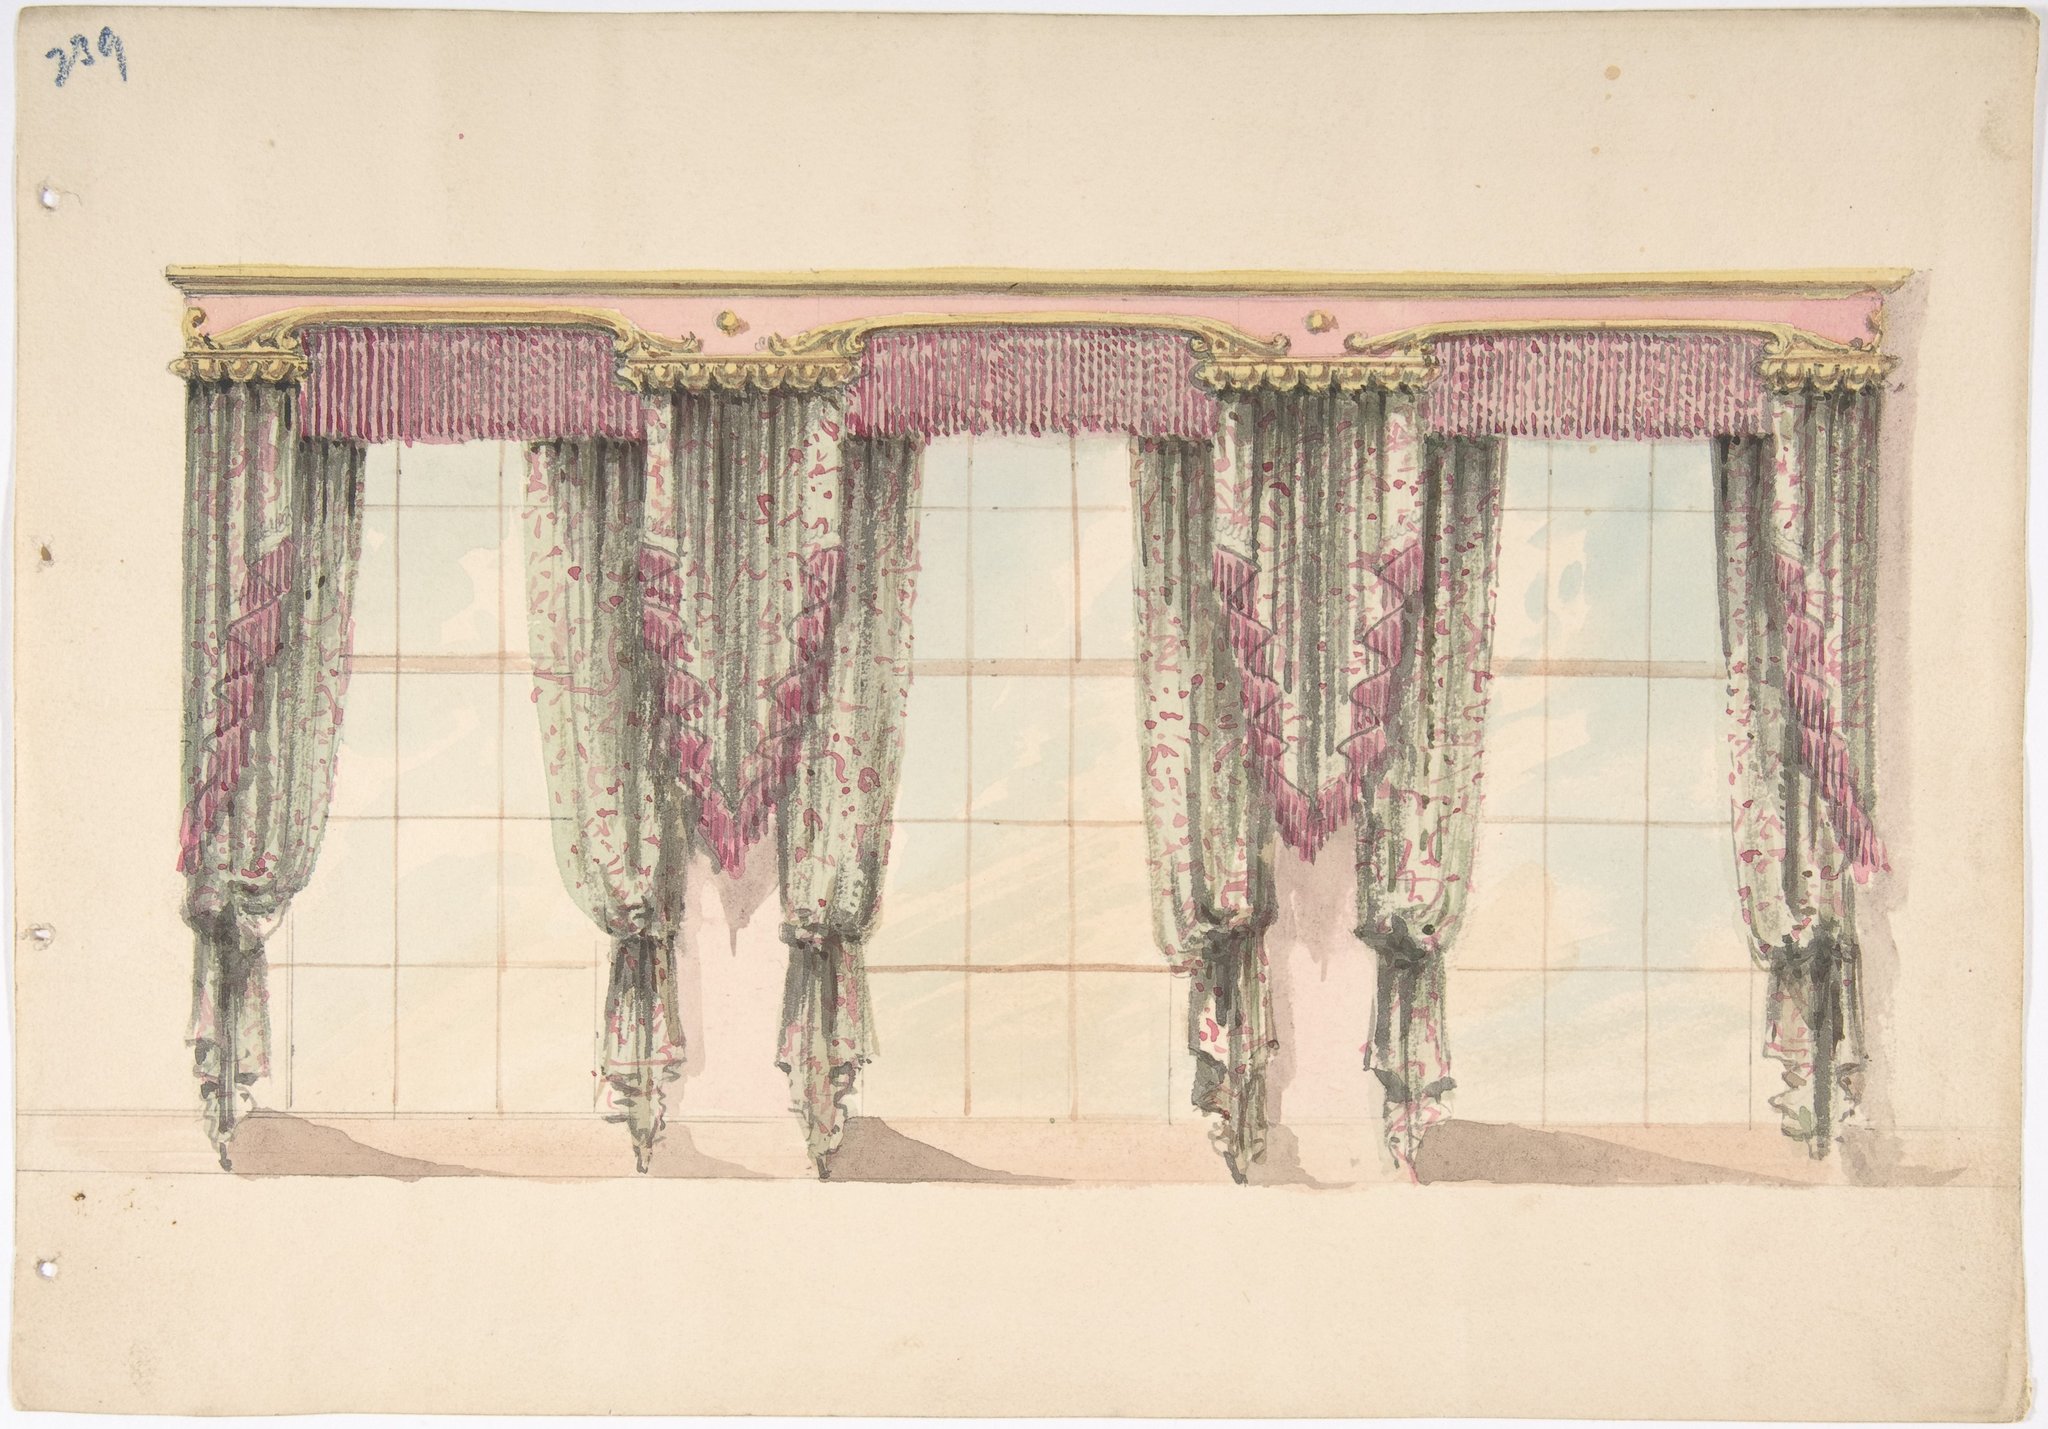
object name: drawing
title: Design for Gray and Pink Curtains with Pink Fringes and a PInk and Gold Pediment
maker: anonymous, british, 19th century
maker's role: artist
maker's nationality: british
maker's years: 1800-1900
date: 1801-1833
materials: ink, watercolor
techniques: brush, pen, wash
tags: windows,curtains